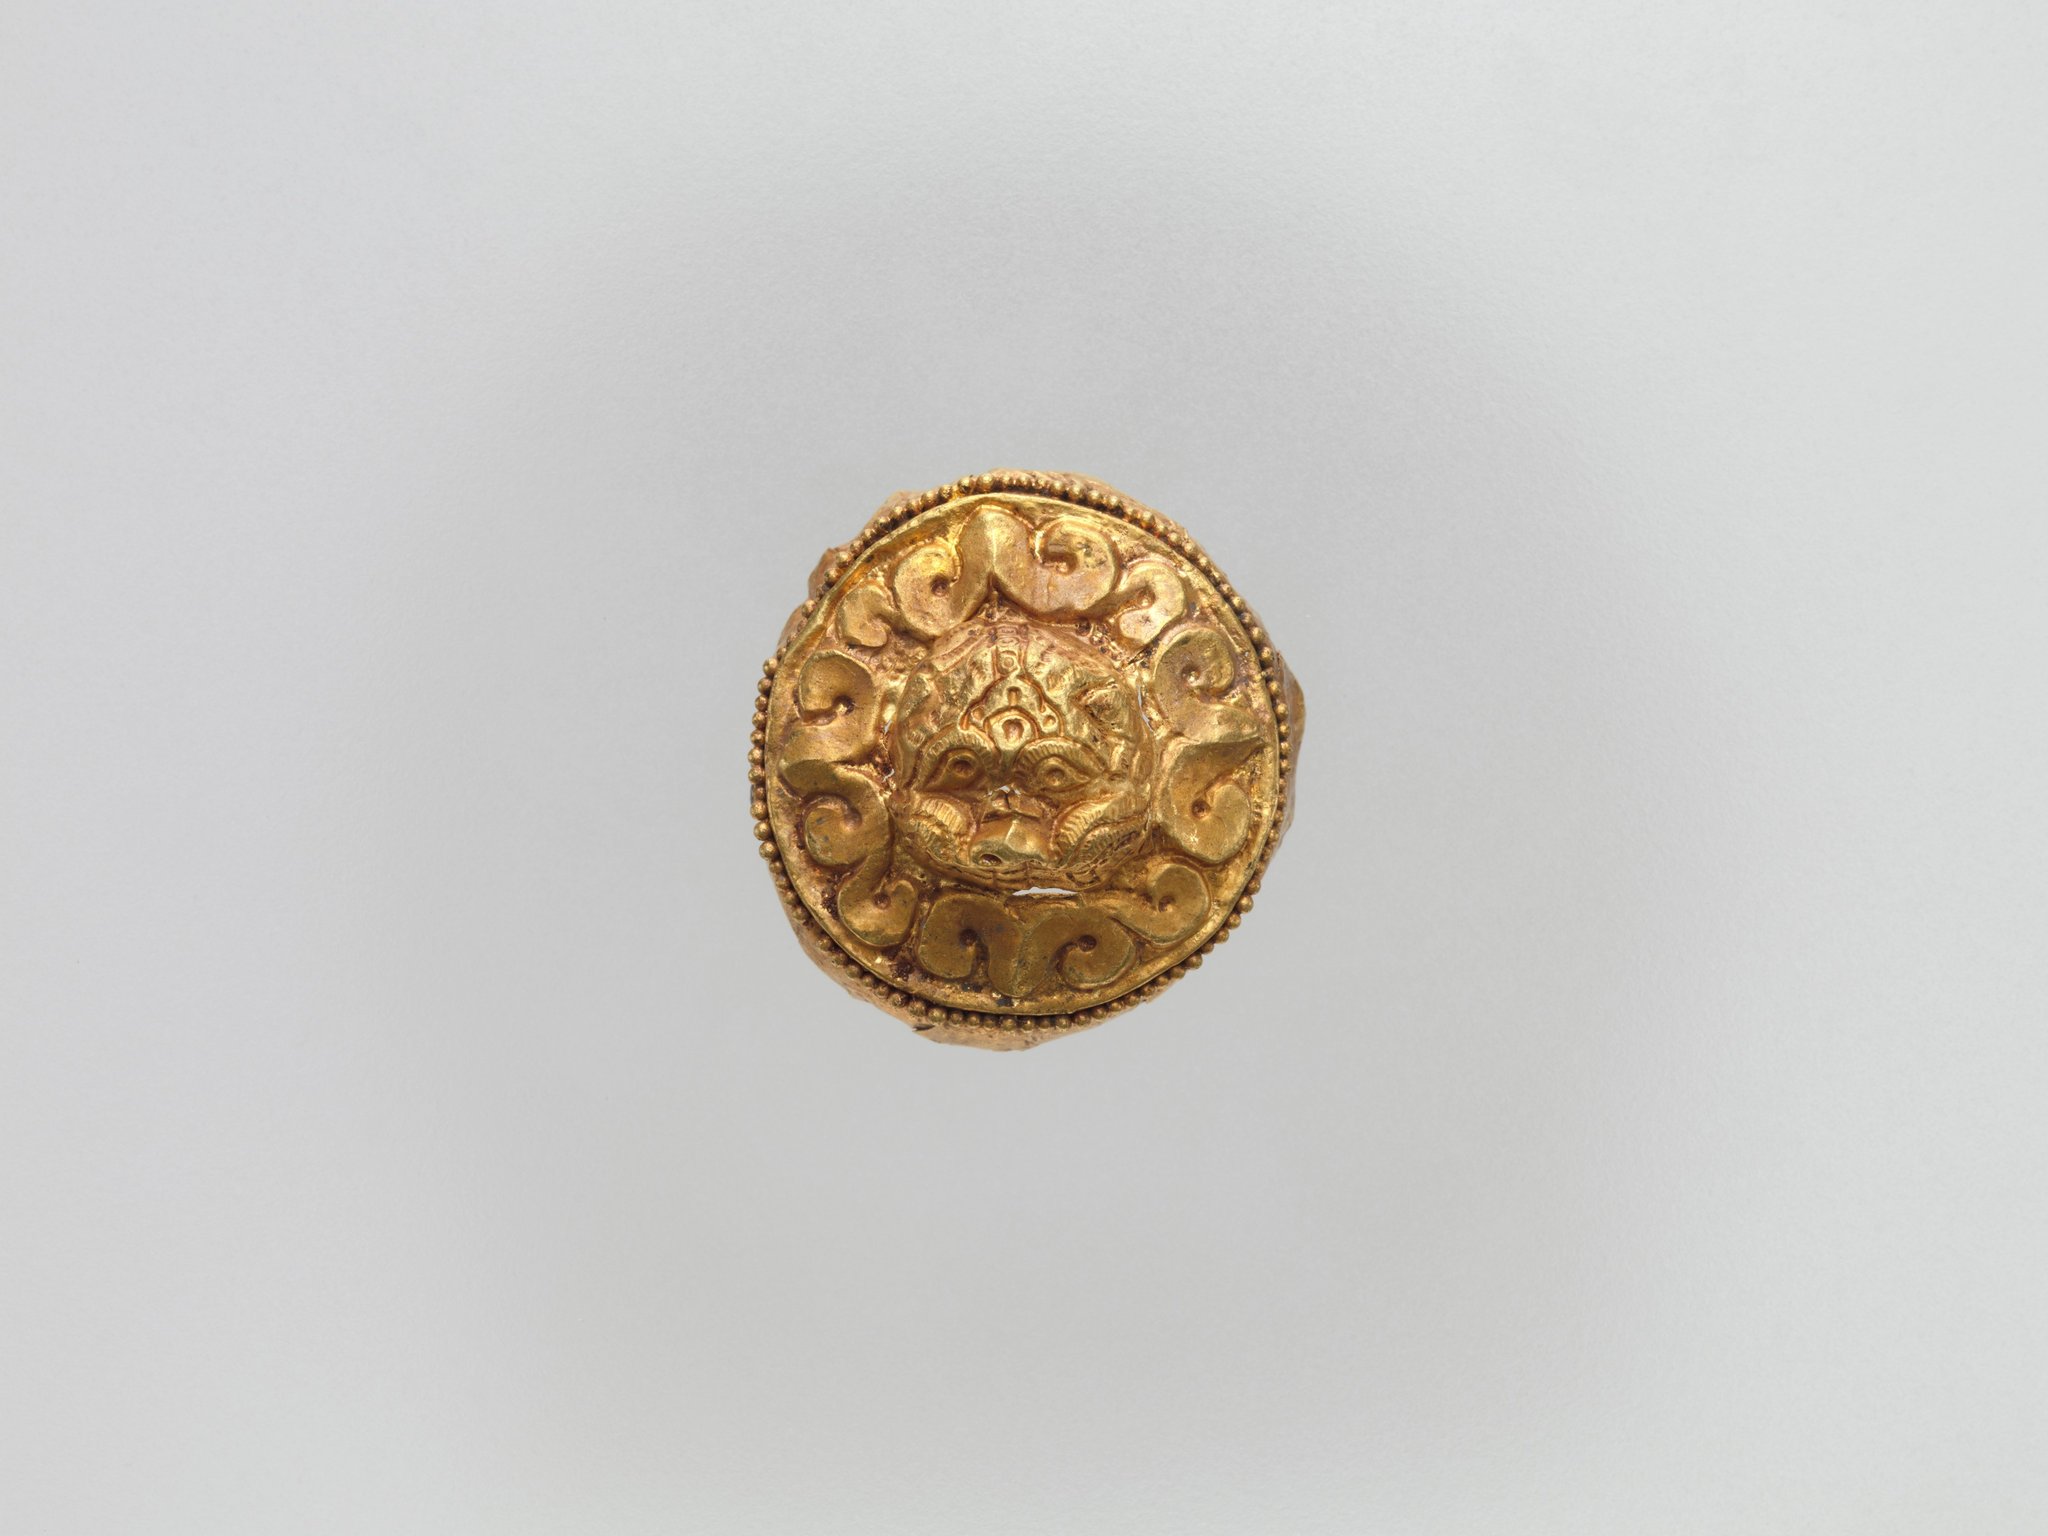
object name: plaque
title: Cap-Shaped Plaque with Lion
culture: chinese or central asian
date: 601-900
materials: gold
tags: lions